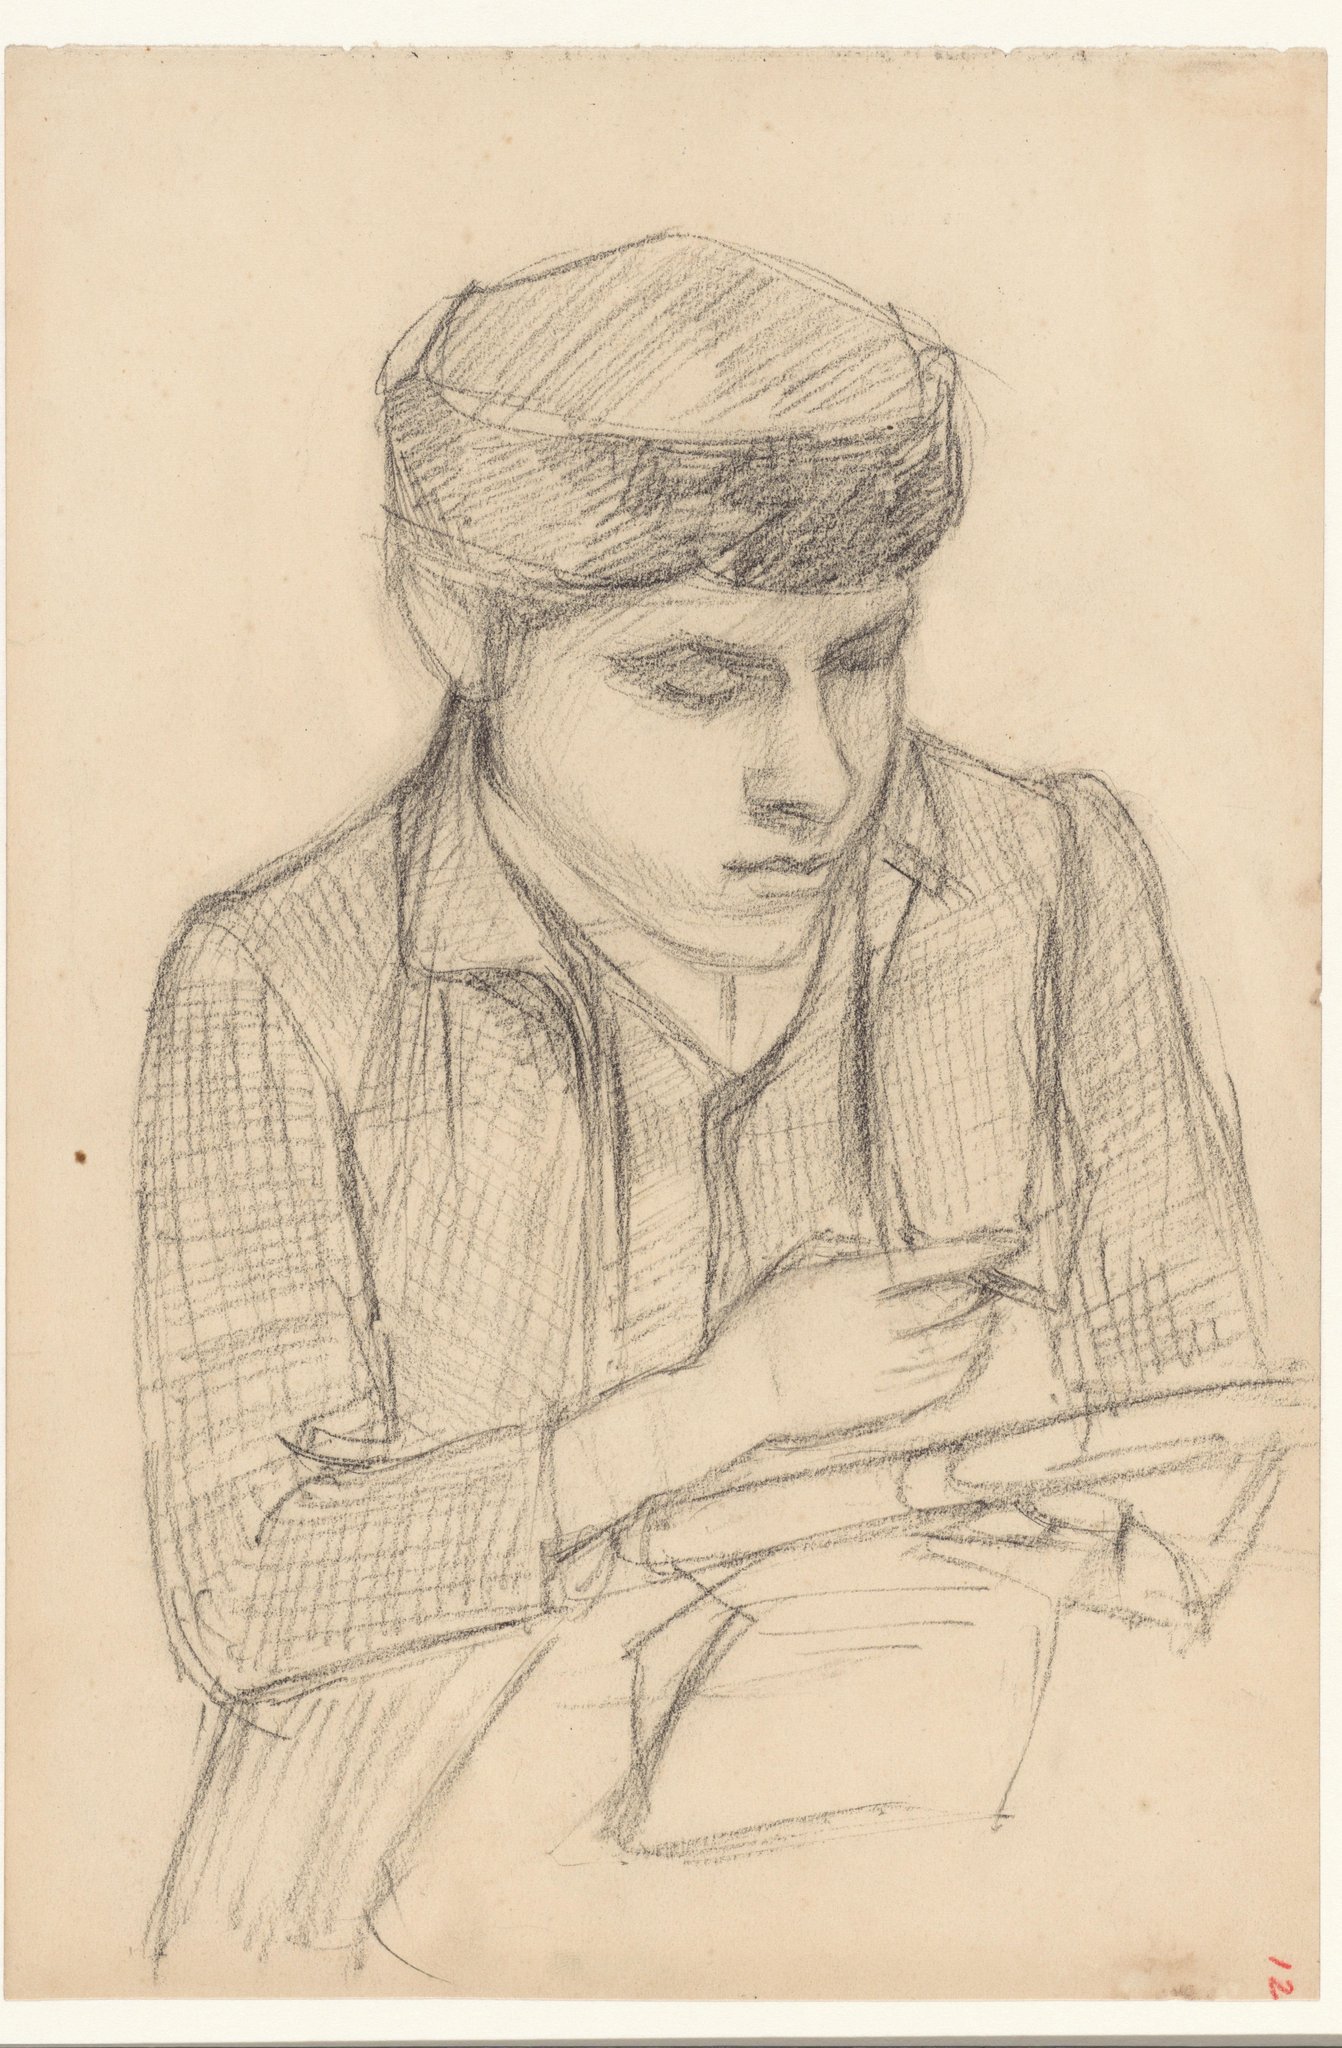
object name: drawing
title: Tekenende jongen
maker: jozef israëls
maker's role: draughtsman, painter, print maker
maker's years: 1824-1911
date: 1834-1911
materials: chalk, paper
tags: draughtsman at work